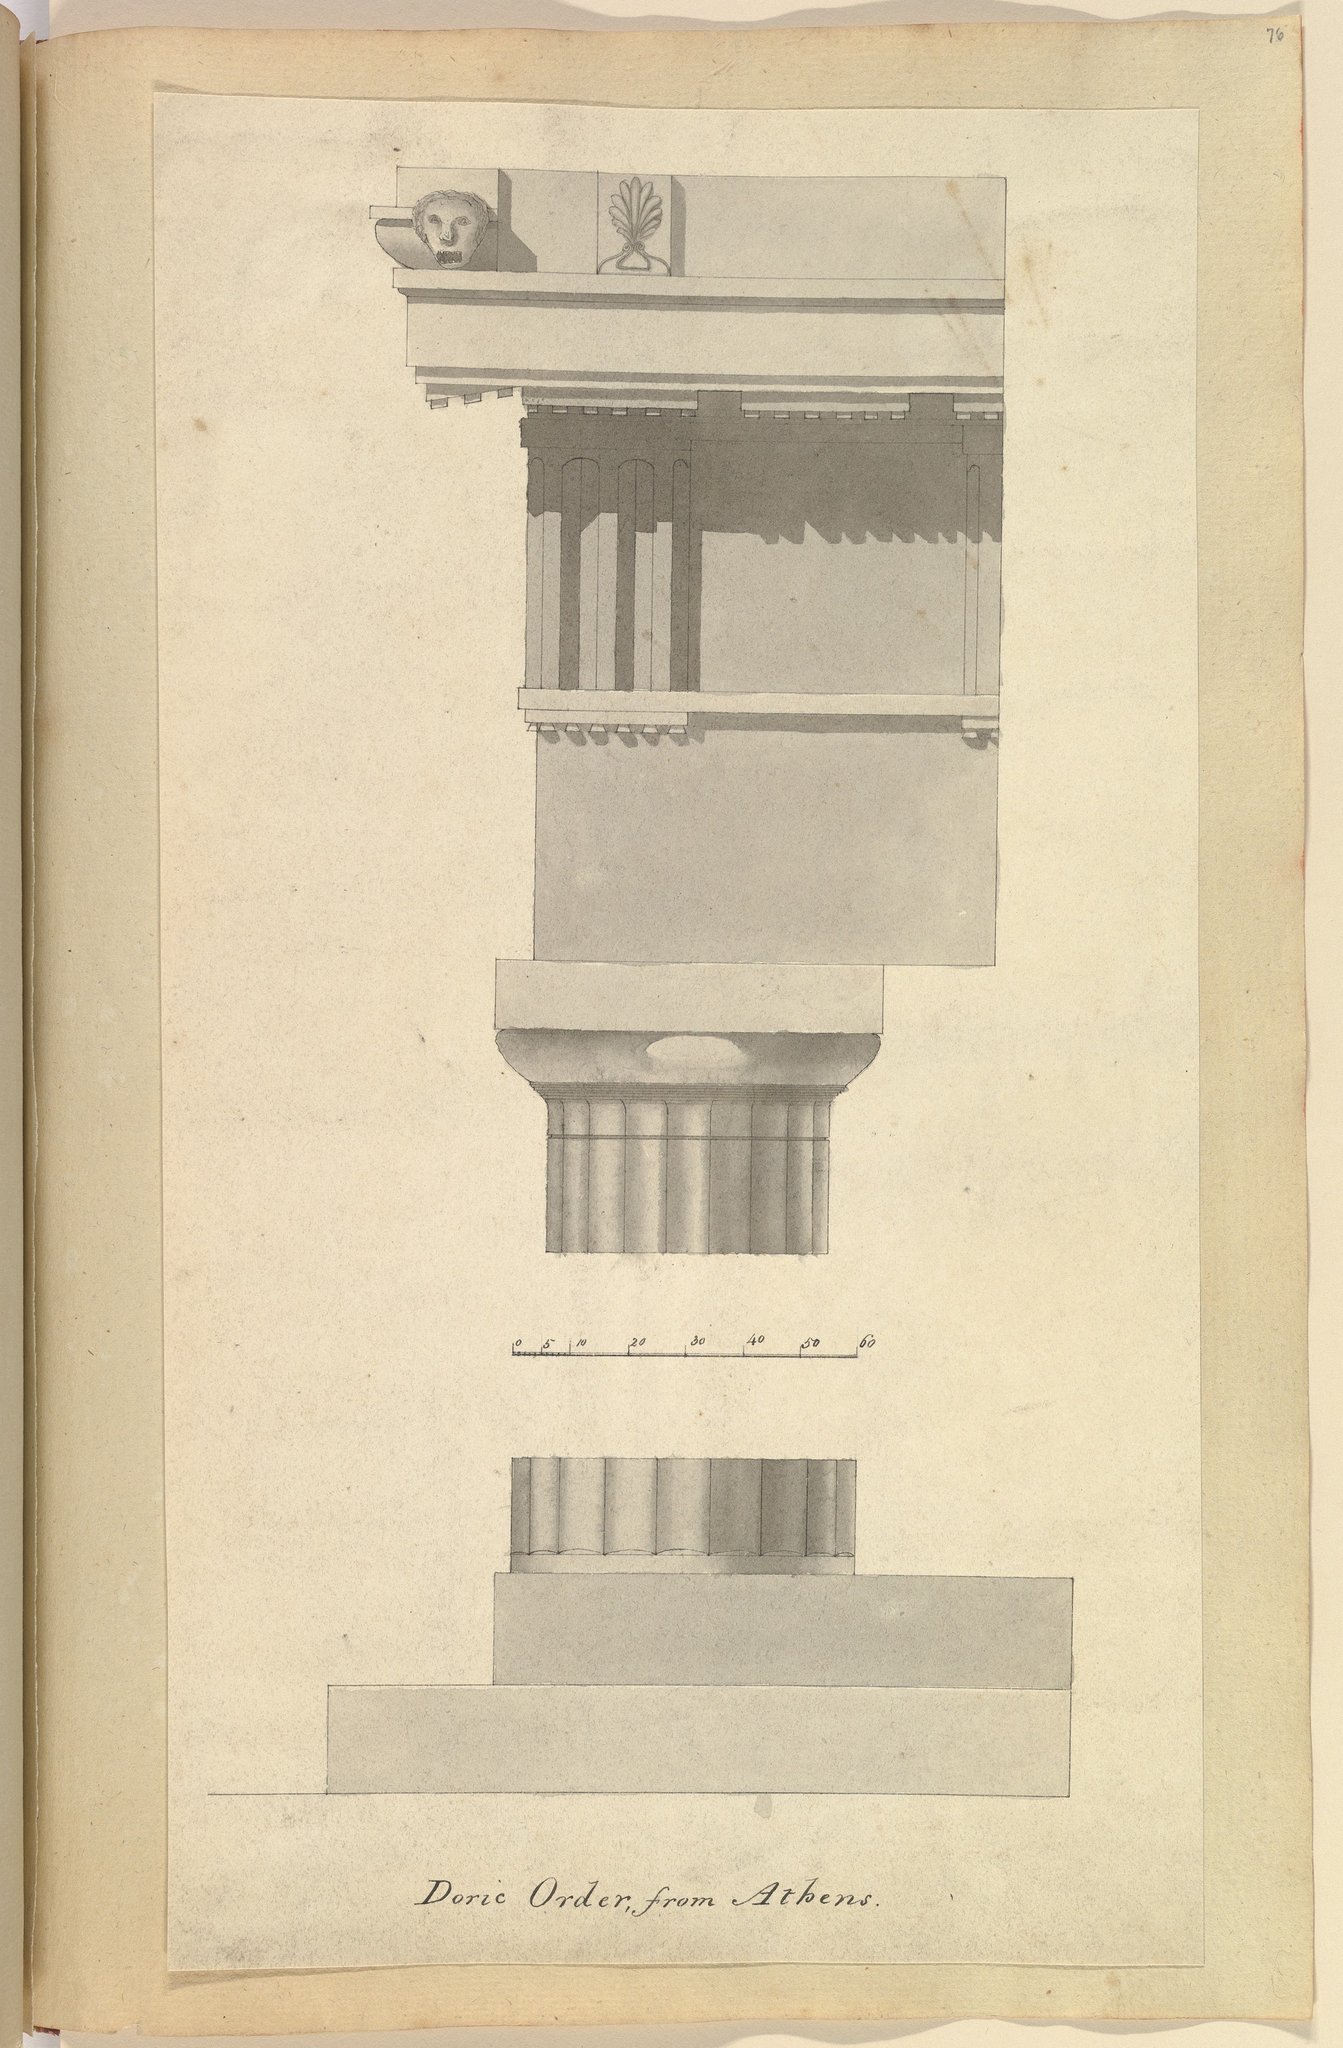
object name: drawing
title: Doric Order from Athens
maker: alfred henry forrester [alfred crowquill]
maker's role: artist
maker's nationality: british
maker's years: 1804-1872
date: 1845-1870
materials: ink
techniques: brush, pen, wash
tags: architecture